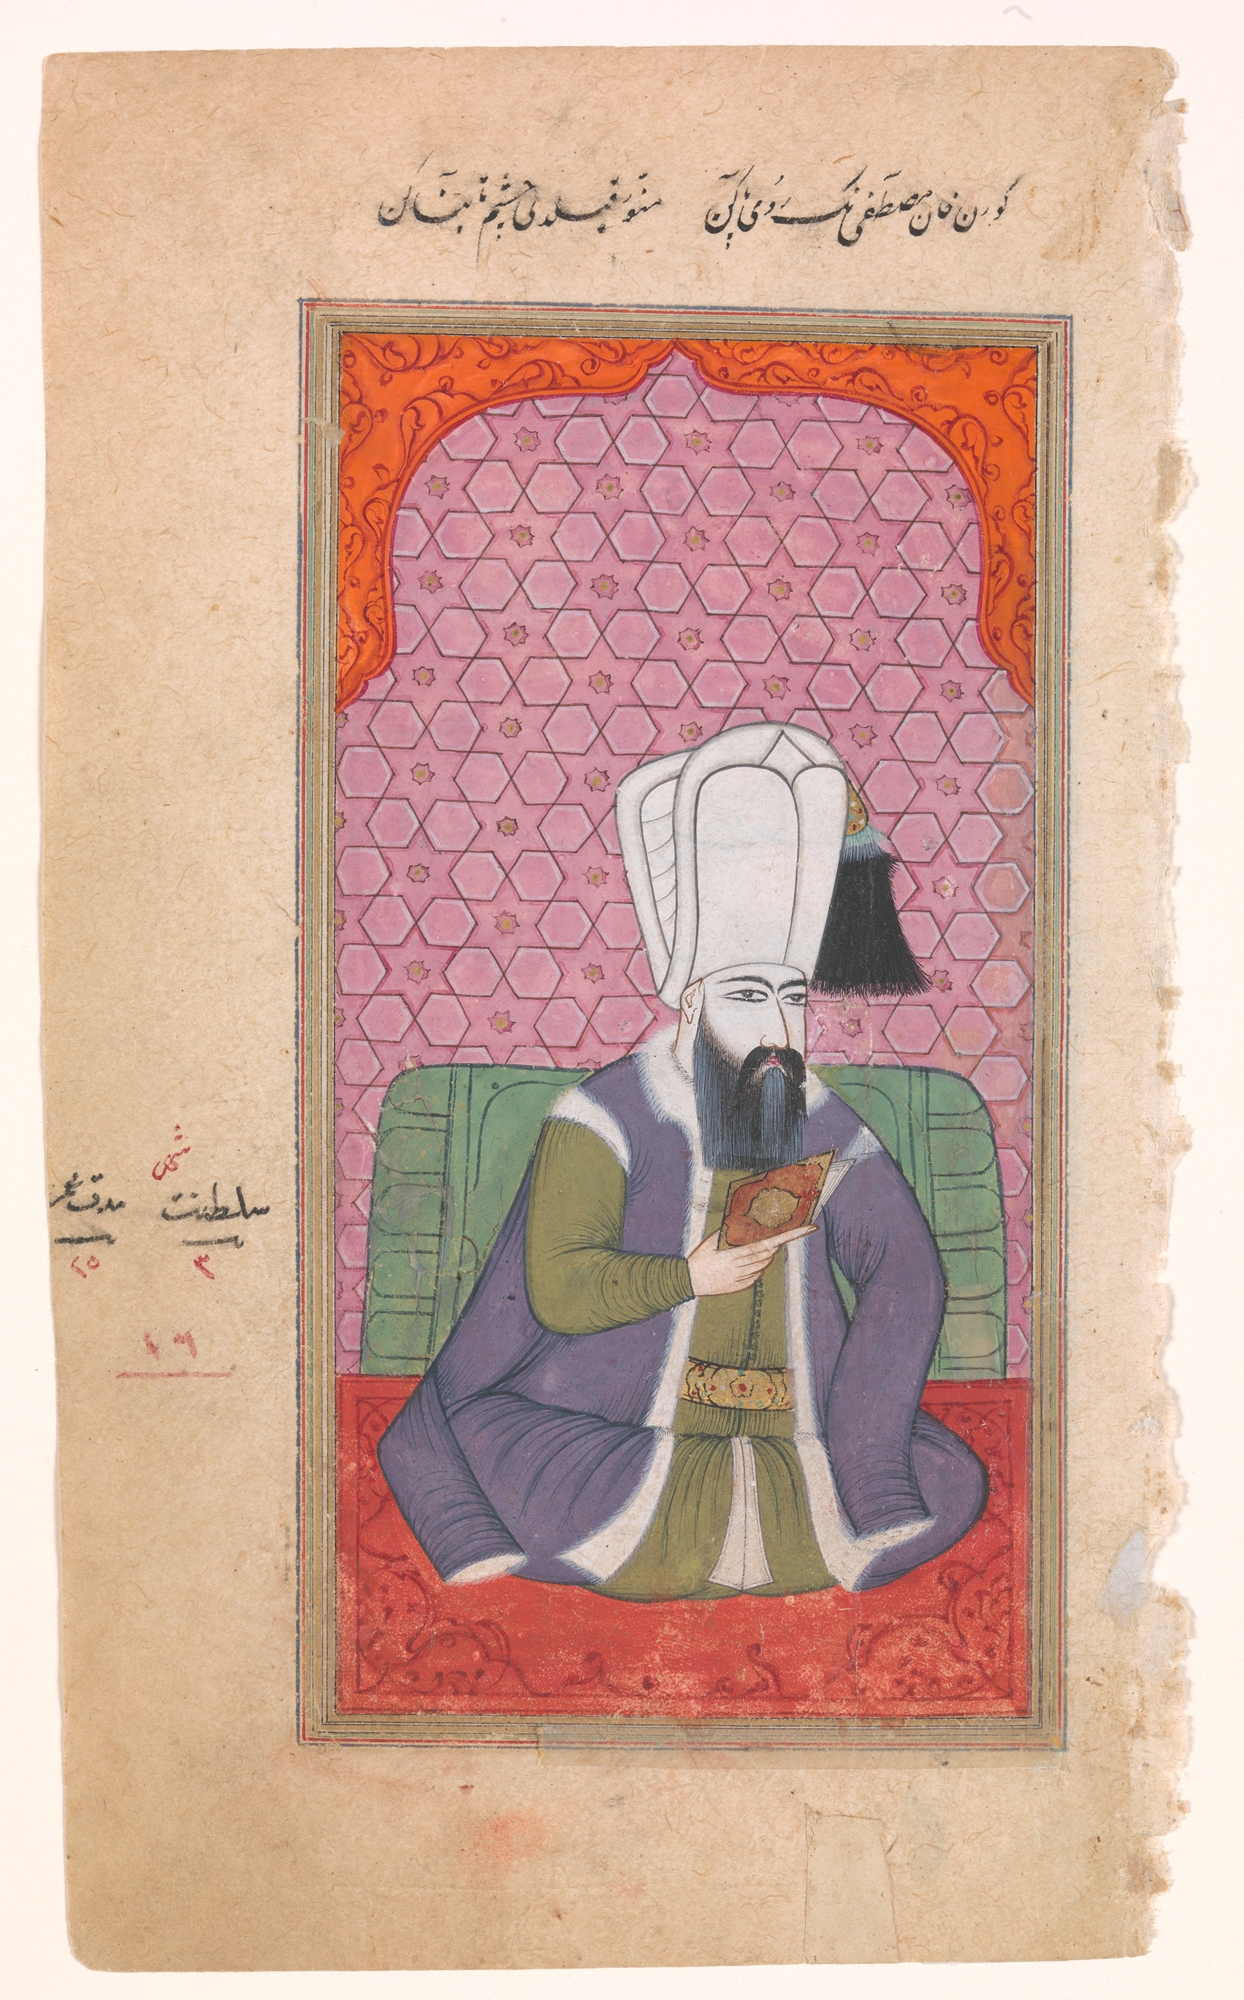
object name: illustrated album leaf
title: Portrait of Sultan Mustafa I (r. 1617–18; 1622–23)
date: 1667-1733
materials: paper, watercolor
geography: turkey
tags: men,portraits